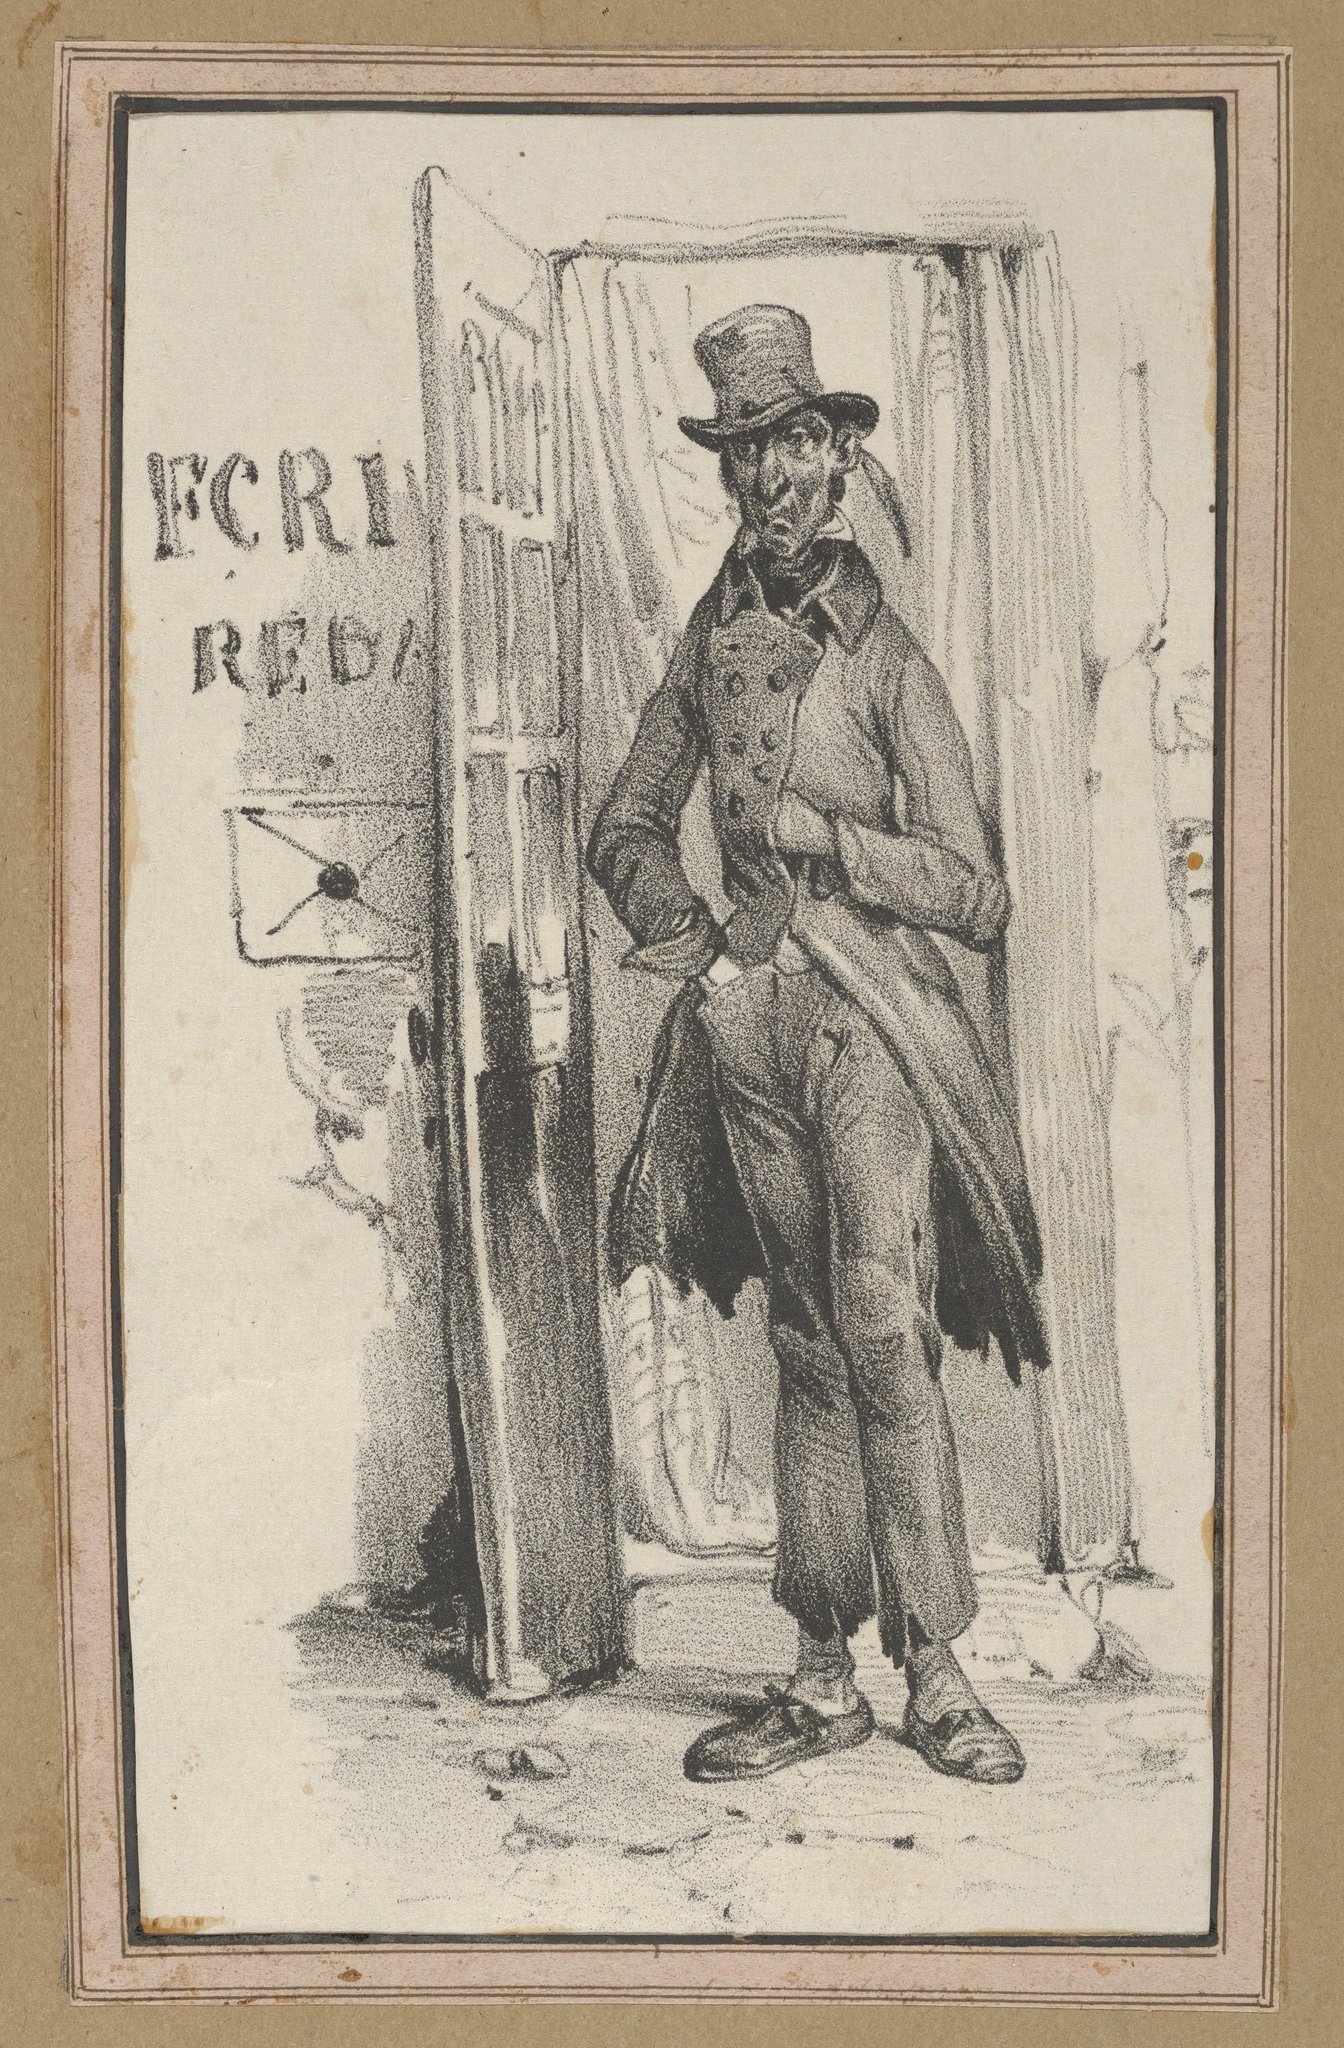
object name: print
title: Man standing in a doorway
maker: victor adam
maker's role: artist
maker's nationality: french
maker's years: 1801-1866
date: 1834-1866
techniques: lithograph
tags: doorways,men,portraits